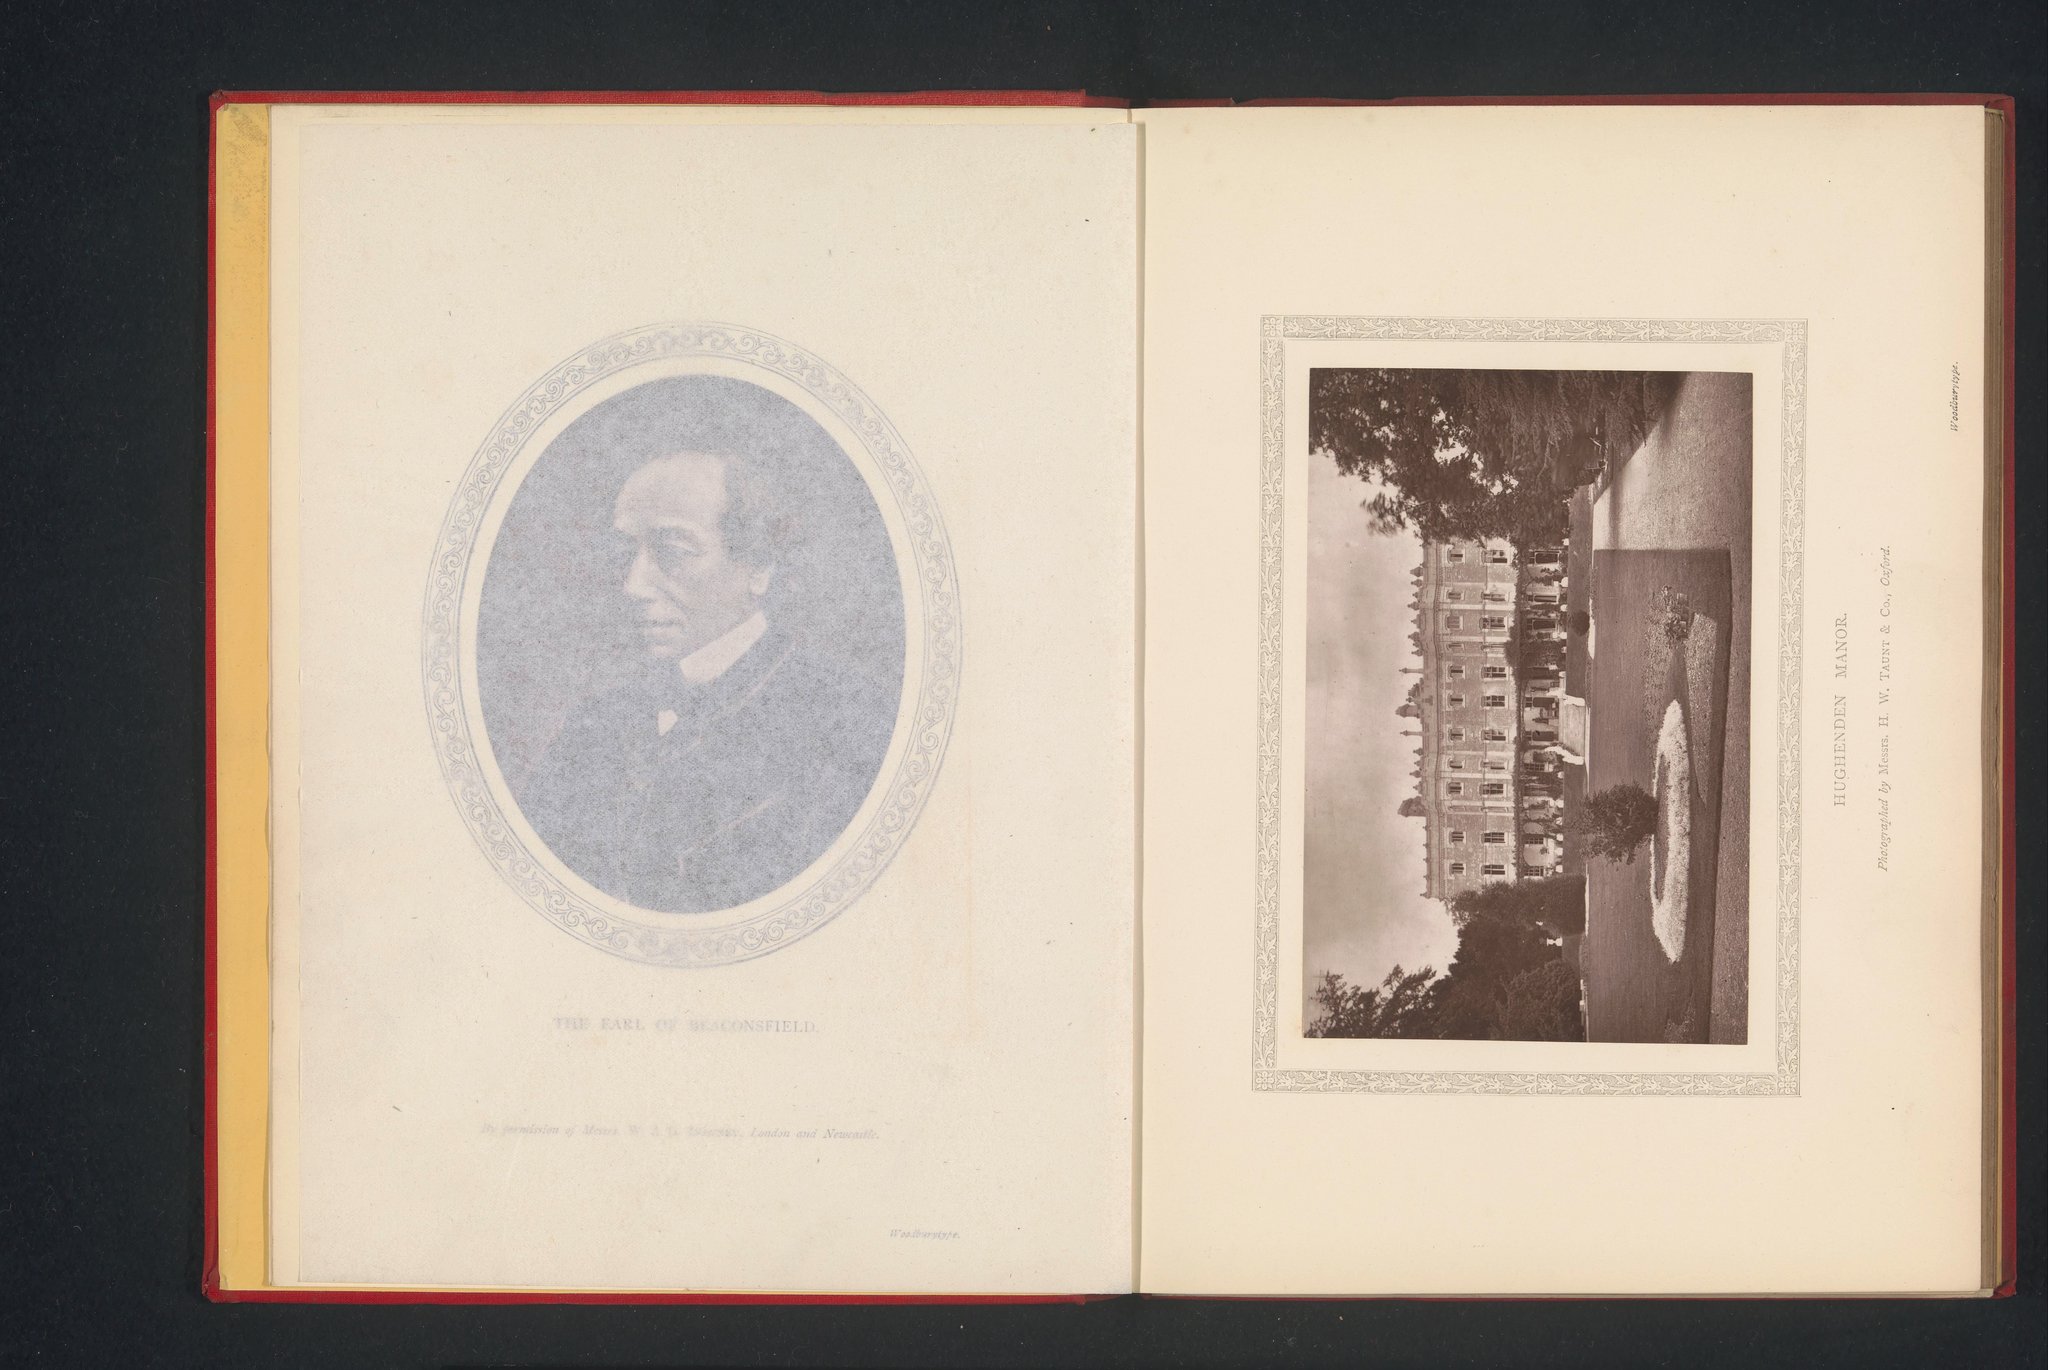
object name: page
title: Hughenden manor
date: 1876-1881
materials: paper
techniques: woodburytype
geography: high wycombe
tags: rural housing, e.g. country-house, villa, cottage